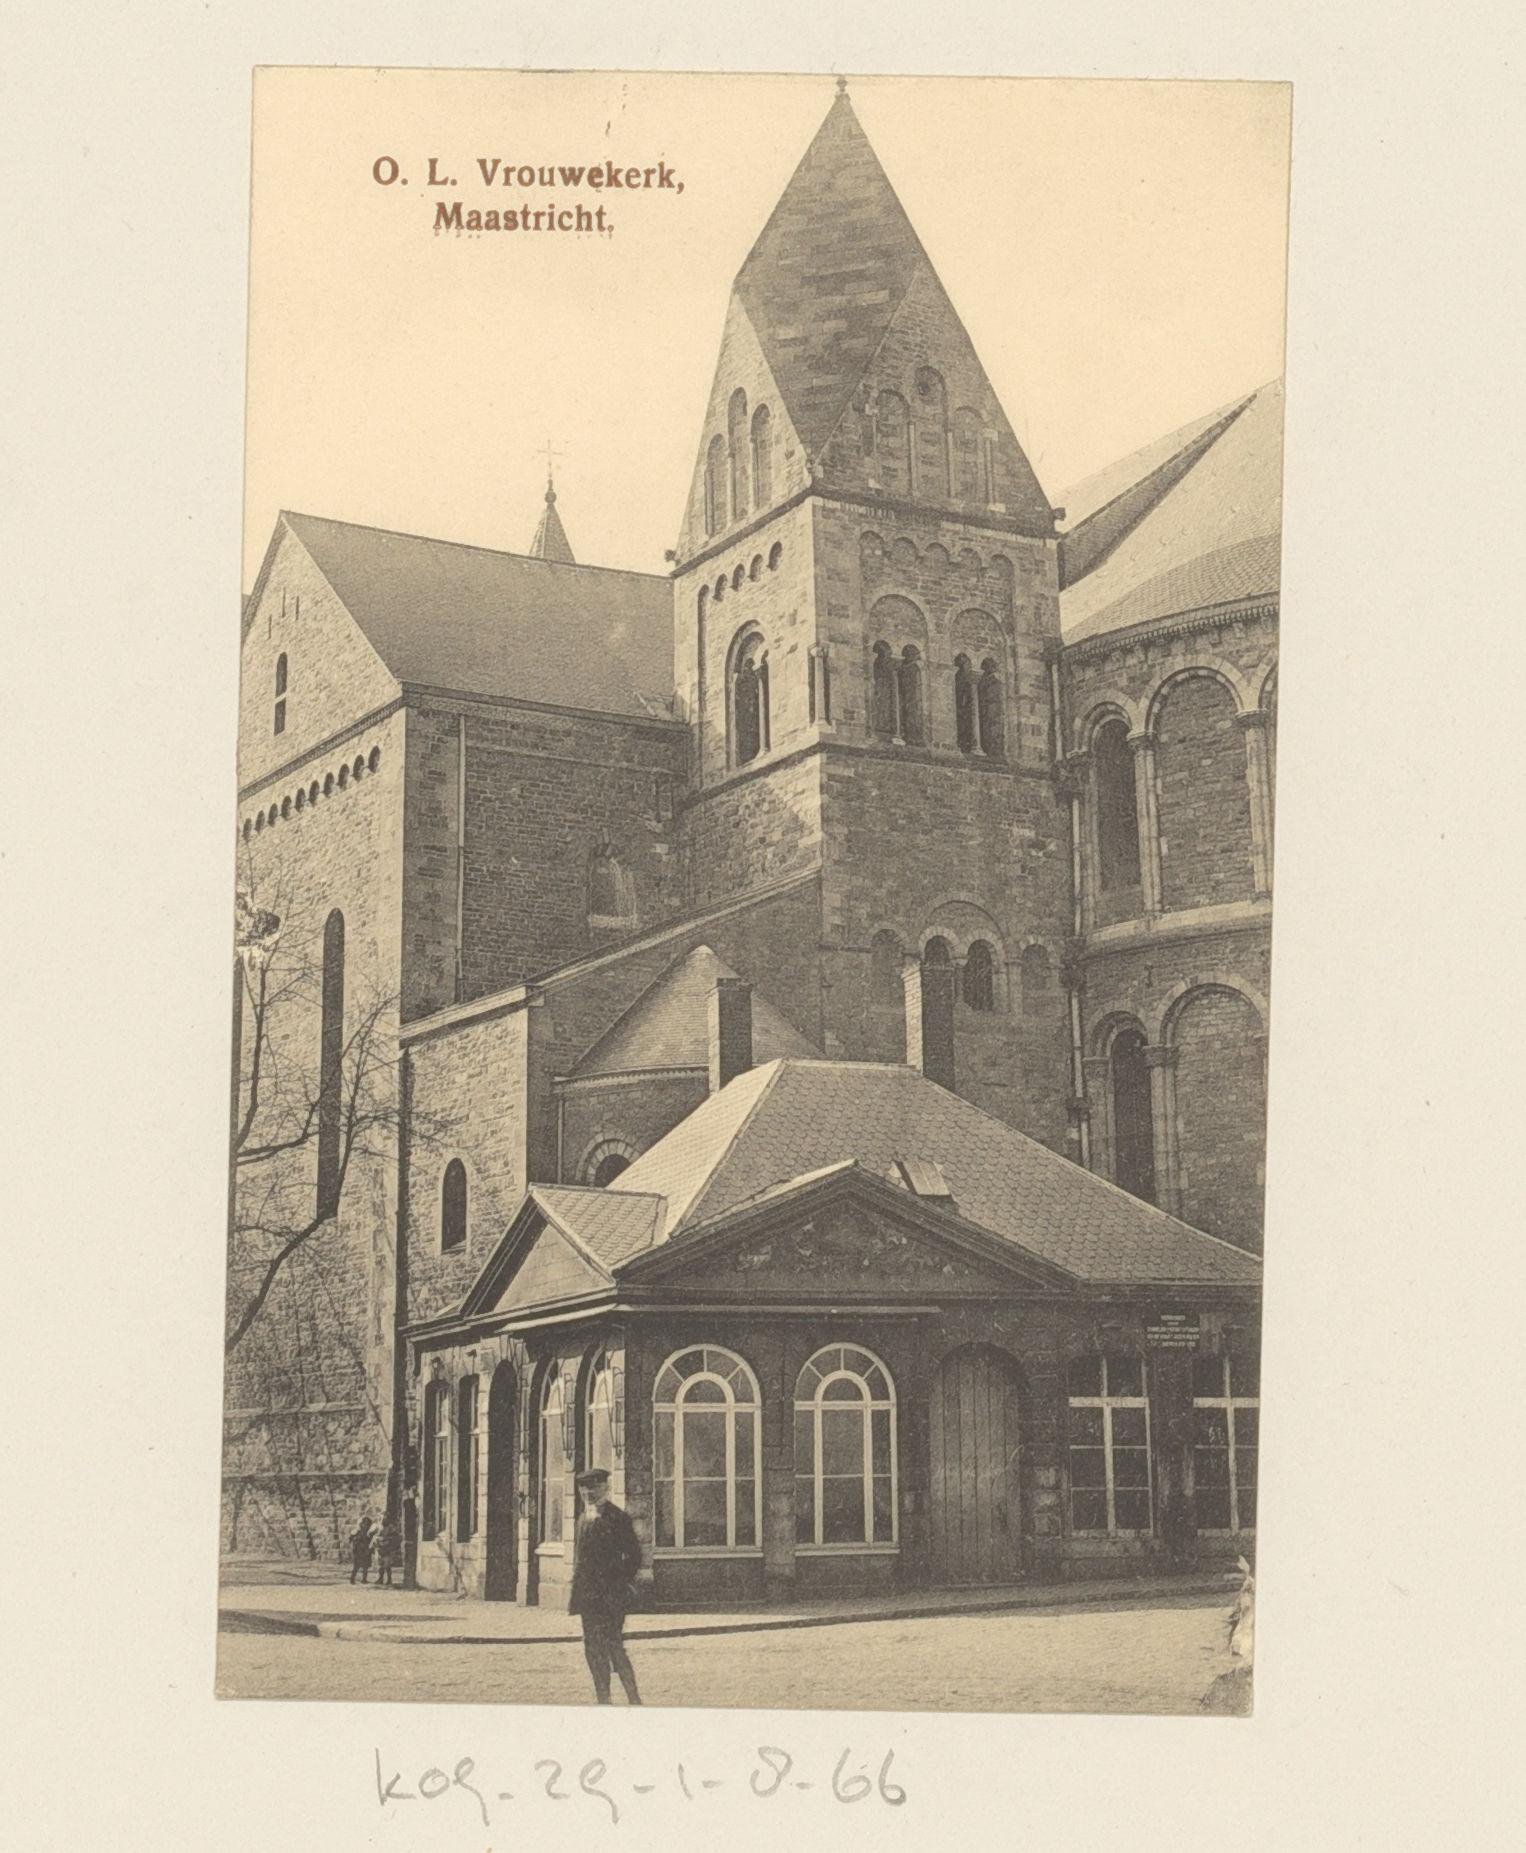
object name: ansichtkaart, prentbriefkaart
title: Gezicht op de Onze-Lieve-Vrouwebasiliek te Maastricht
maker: Anonymous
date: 1880-1920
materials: cardboard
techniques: photograph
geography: maastricht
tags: church (exterior)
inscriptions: collector's mark: Lugt 1641, collector's mark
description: Gezicht op de Onze-Lieve-Vrouwebasiliek te Maastricht. Onderwerpsrubrieken binnen de Atlas Zeden en Gewoonten: Kerk en kerkwezen & Armwezen en liefdadige instellingen; Kerkgebouwen elders. M-U.